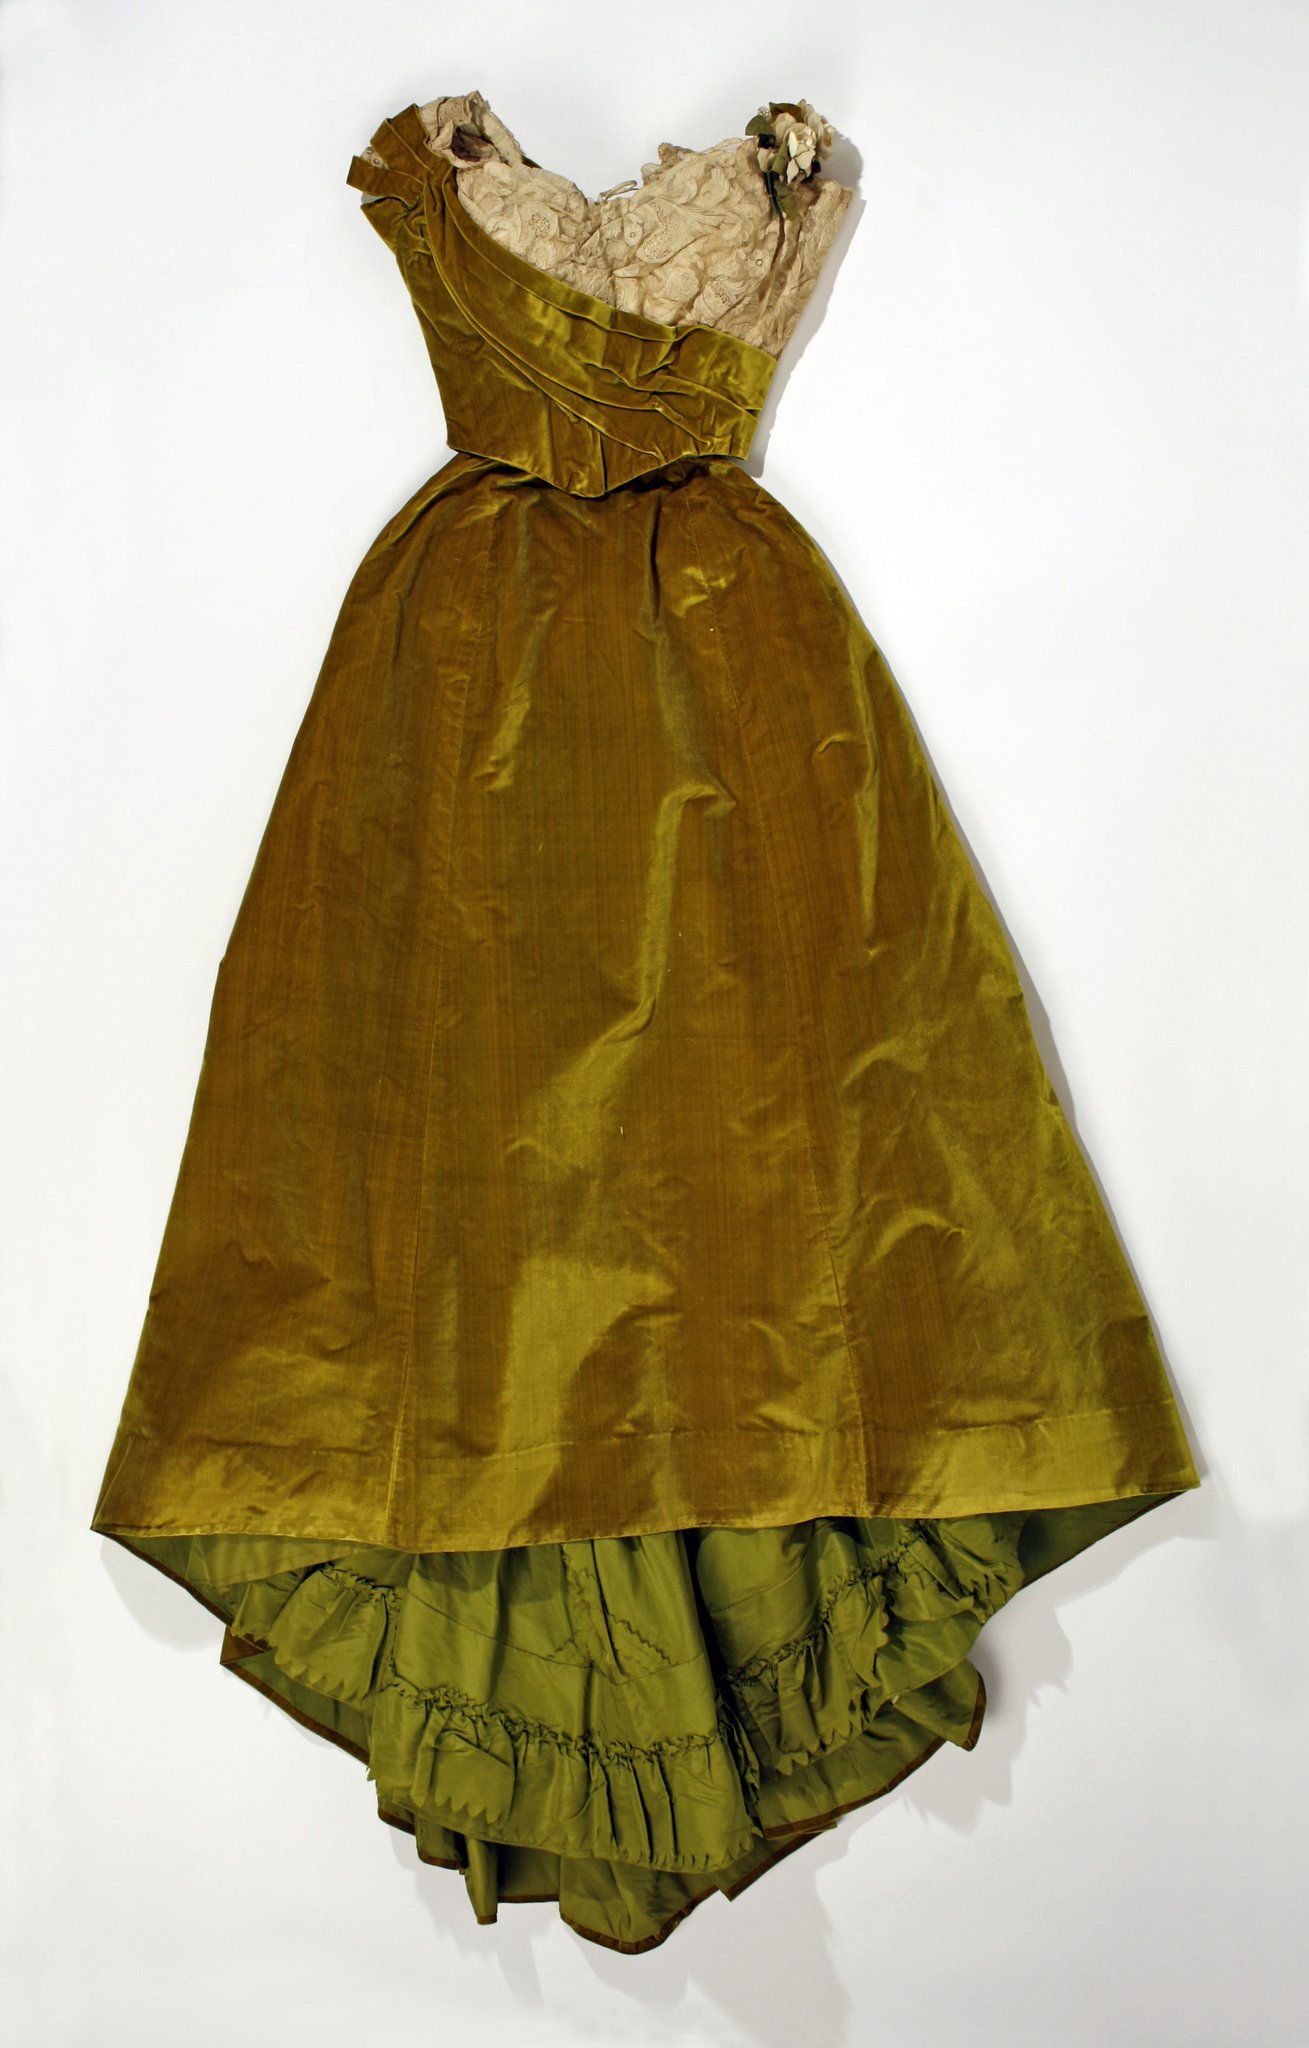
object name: evening dress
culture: french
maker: house of worth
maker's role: design house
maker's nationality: french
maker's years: 1858-1956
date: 1899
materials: silk